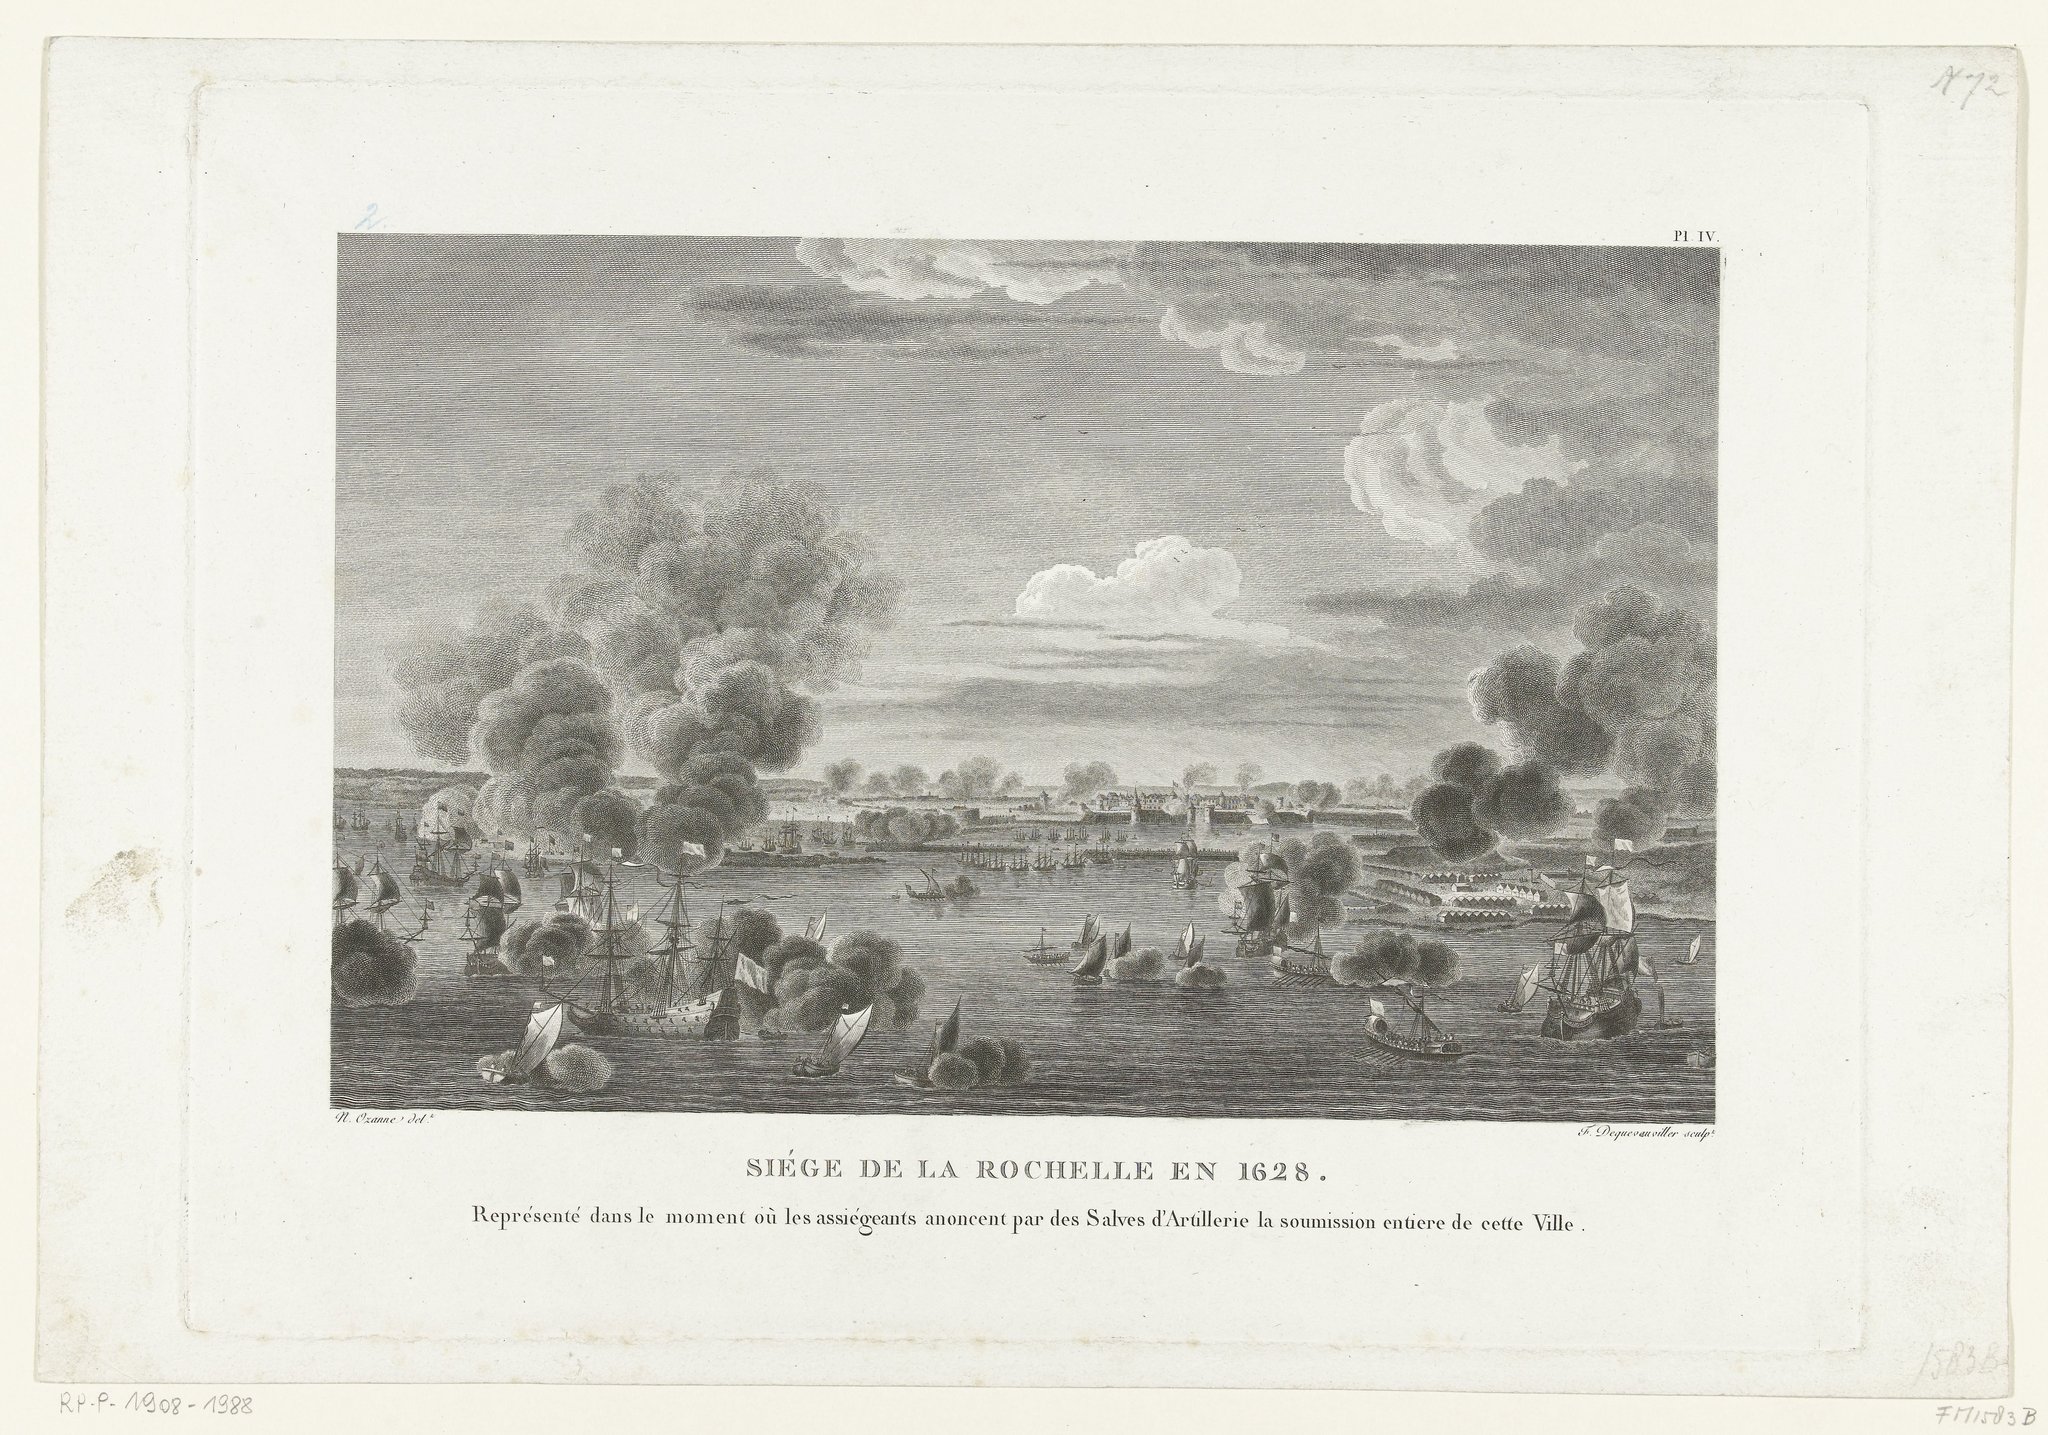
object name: history print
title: Siège de la Rochelle en 1628. Représenté dans le moment ou les assiégeants anoncent par des Salves d'Artillerie la soumission entiere de cette Ville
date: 1794-1796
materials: paper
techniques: etching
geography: france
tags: armand-jean du plessis hertog van richelieu, capture of city (after the siege), cannon shots (military salute)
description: De overgave van de opstandige Franse stad La Rochelle na beleg door het Staatse leger en het koninklijke Franse leger onder kardinaal Richelieu van september 1627 - oktober 1628. De overgave van de stad op 28 oktober 1628 wordt gevierd door het afvuren van een salvo door artillerie en schepen op het water. Gemerkt linksboven Pl. IV.